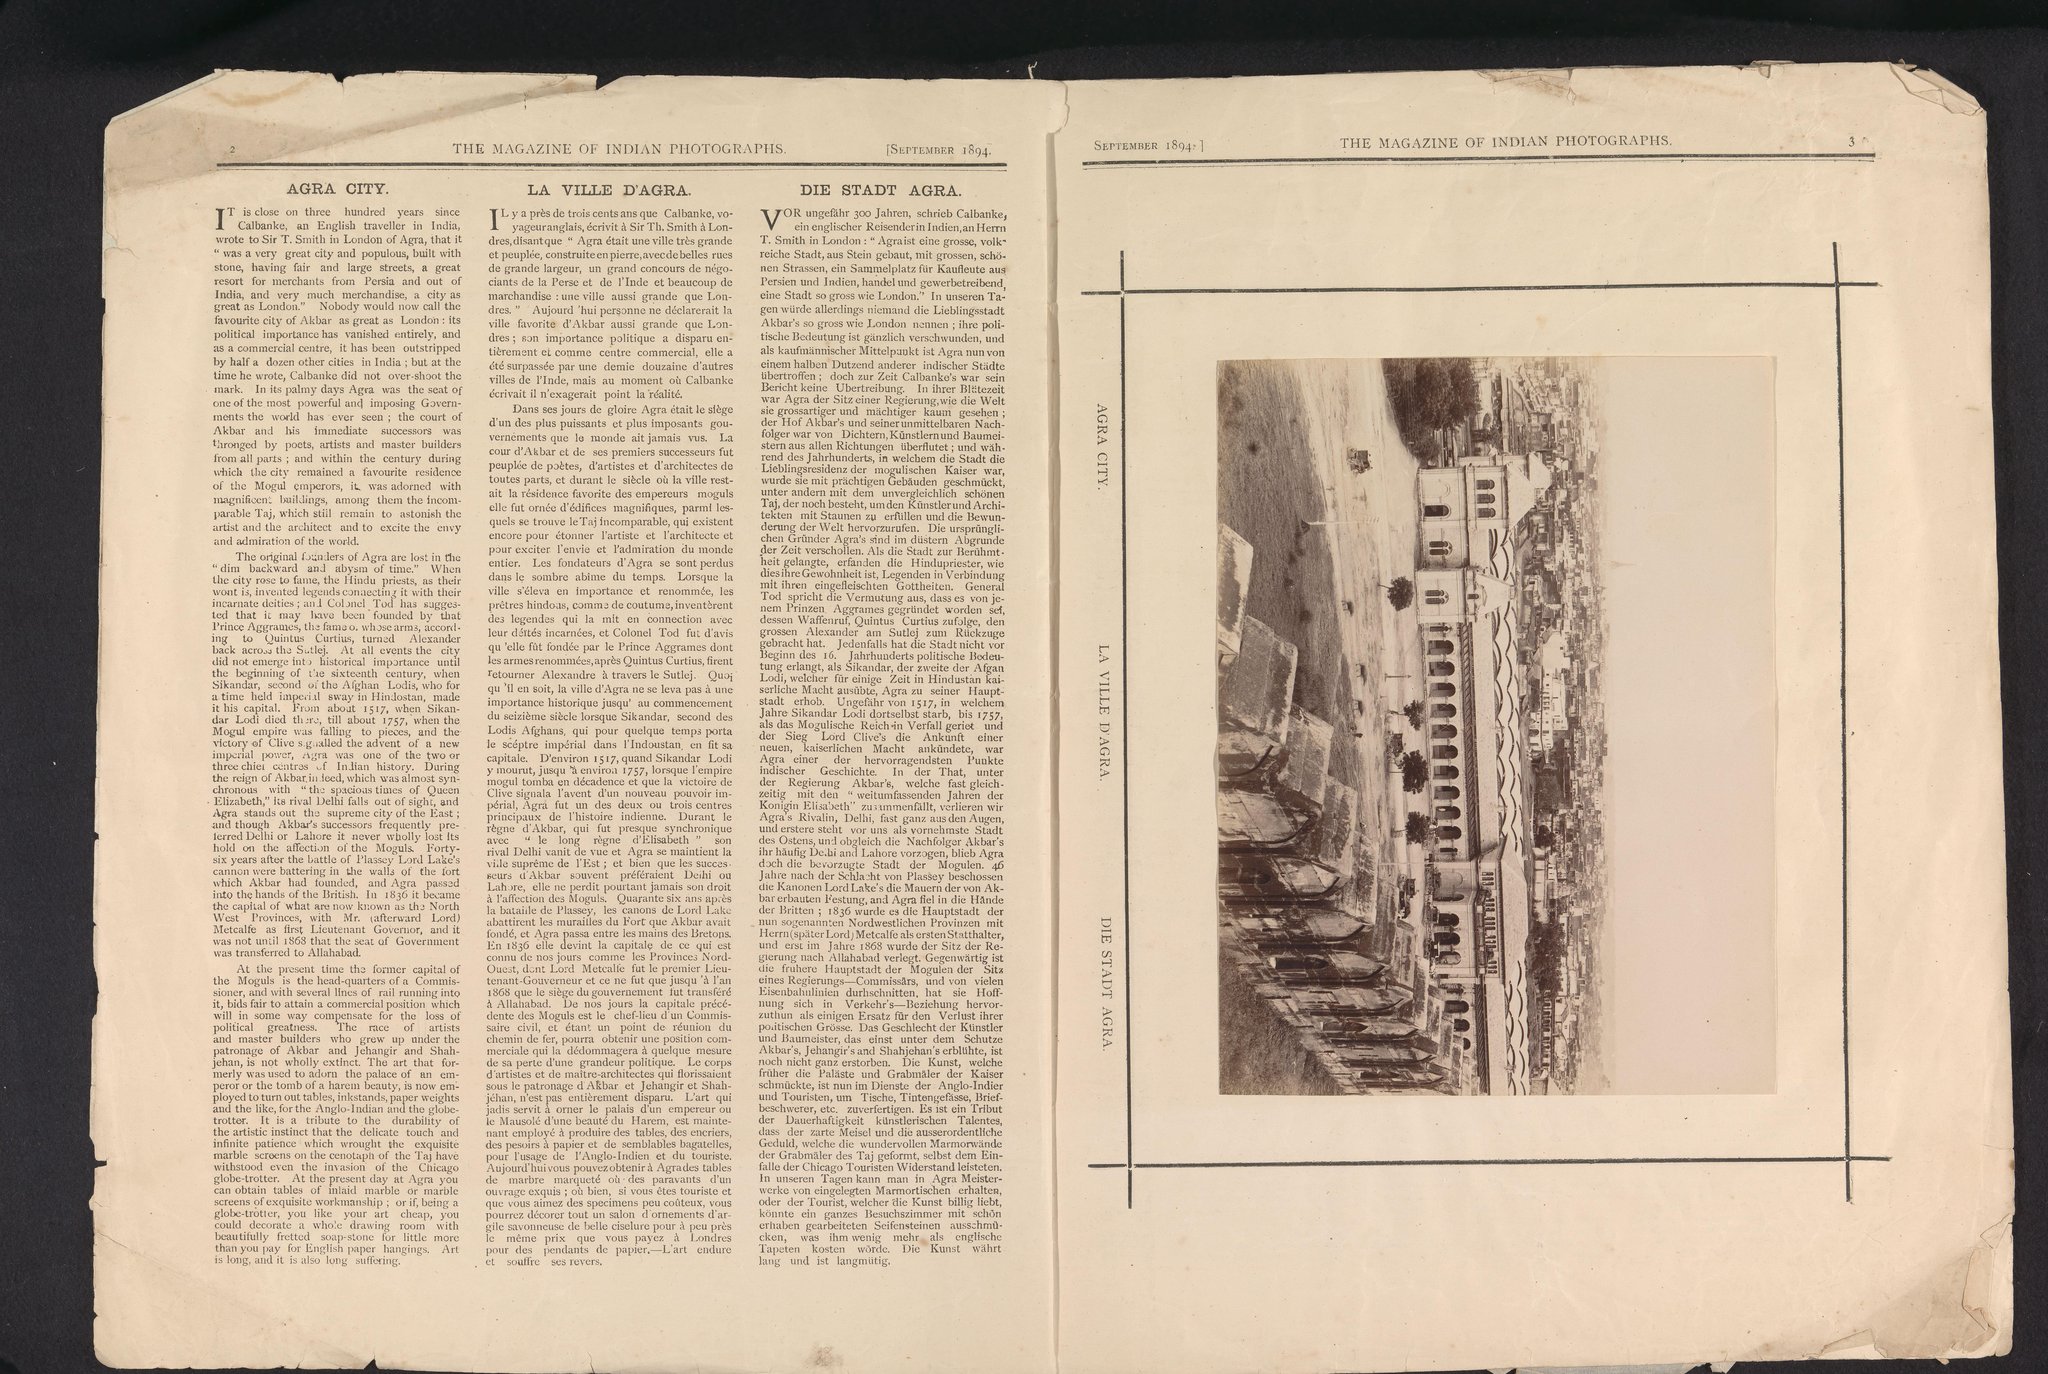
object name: photograph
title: View of Agra, Uttar Pradesh, India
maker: Anonymous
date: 1889-1894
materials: photographic support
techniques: albumen print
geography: agra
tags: city-view in general; 'veduta'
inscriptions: title: ‘AGRA CITY. LA VILLE D'AGRA. DIE STADT AGRA.’